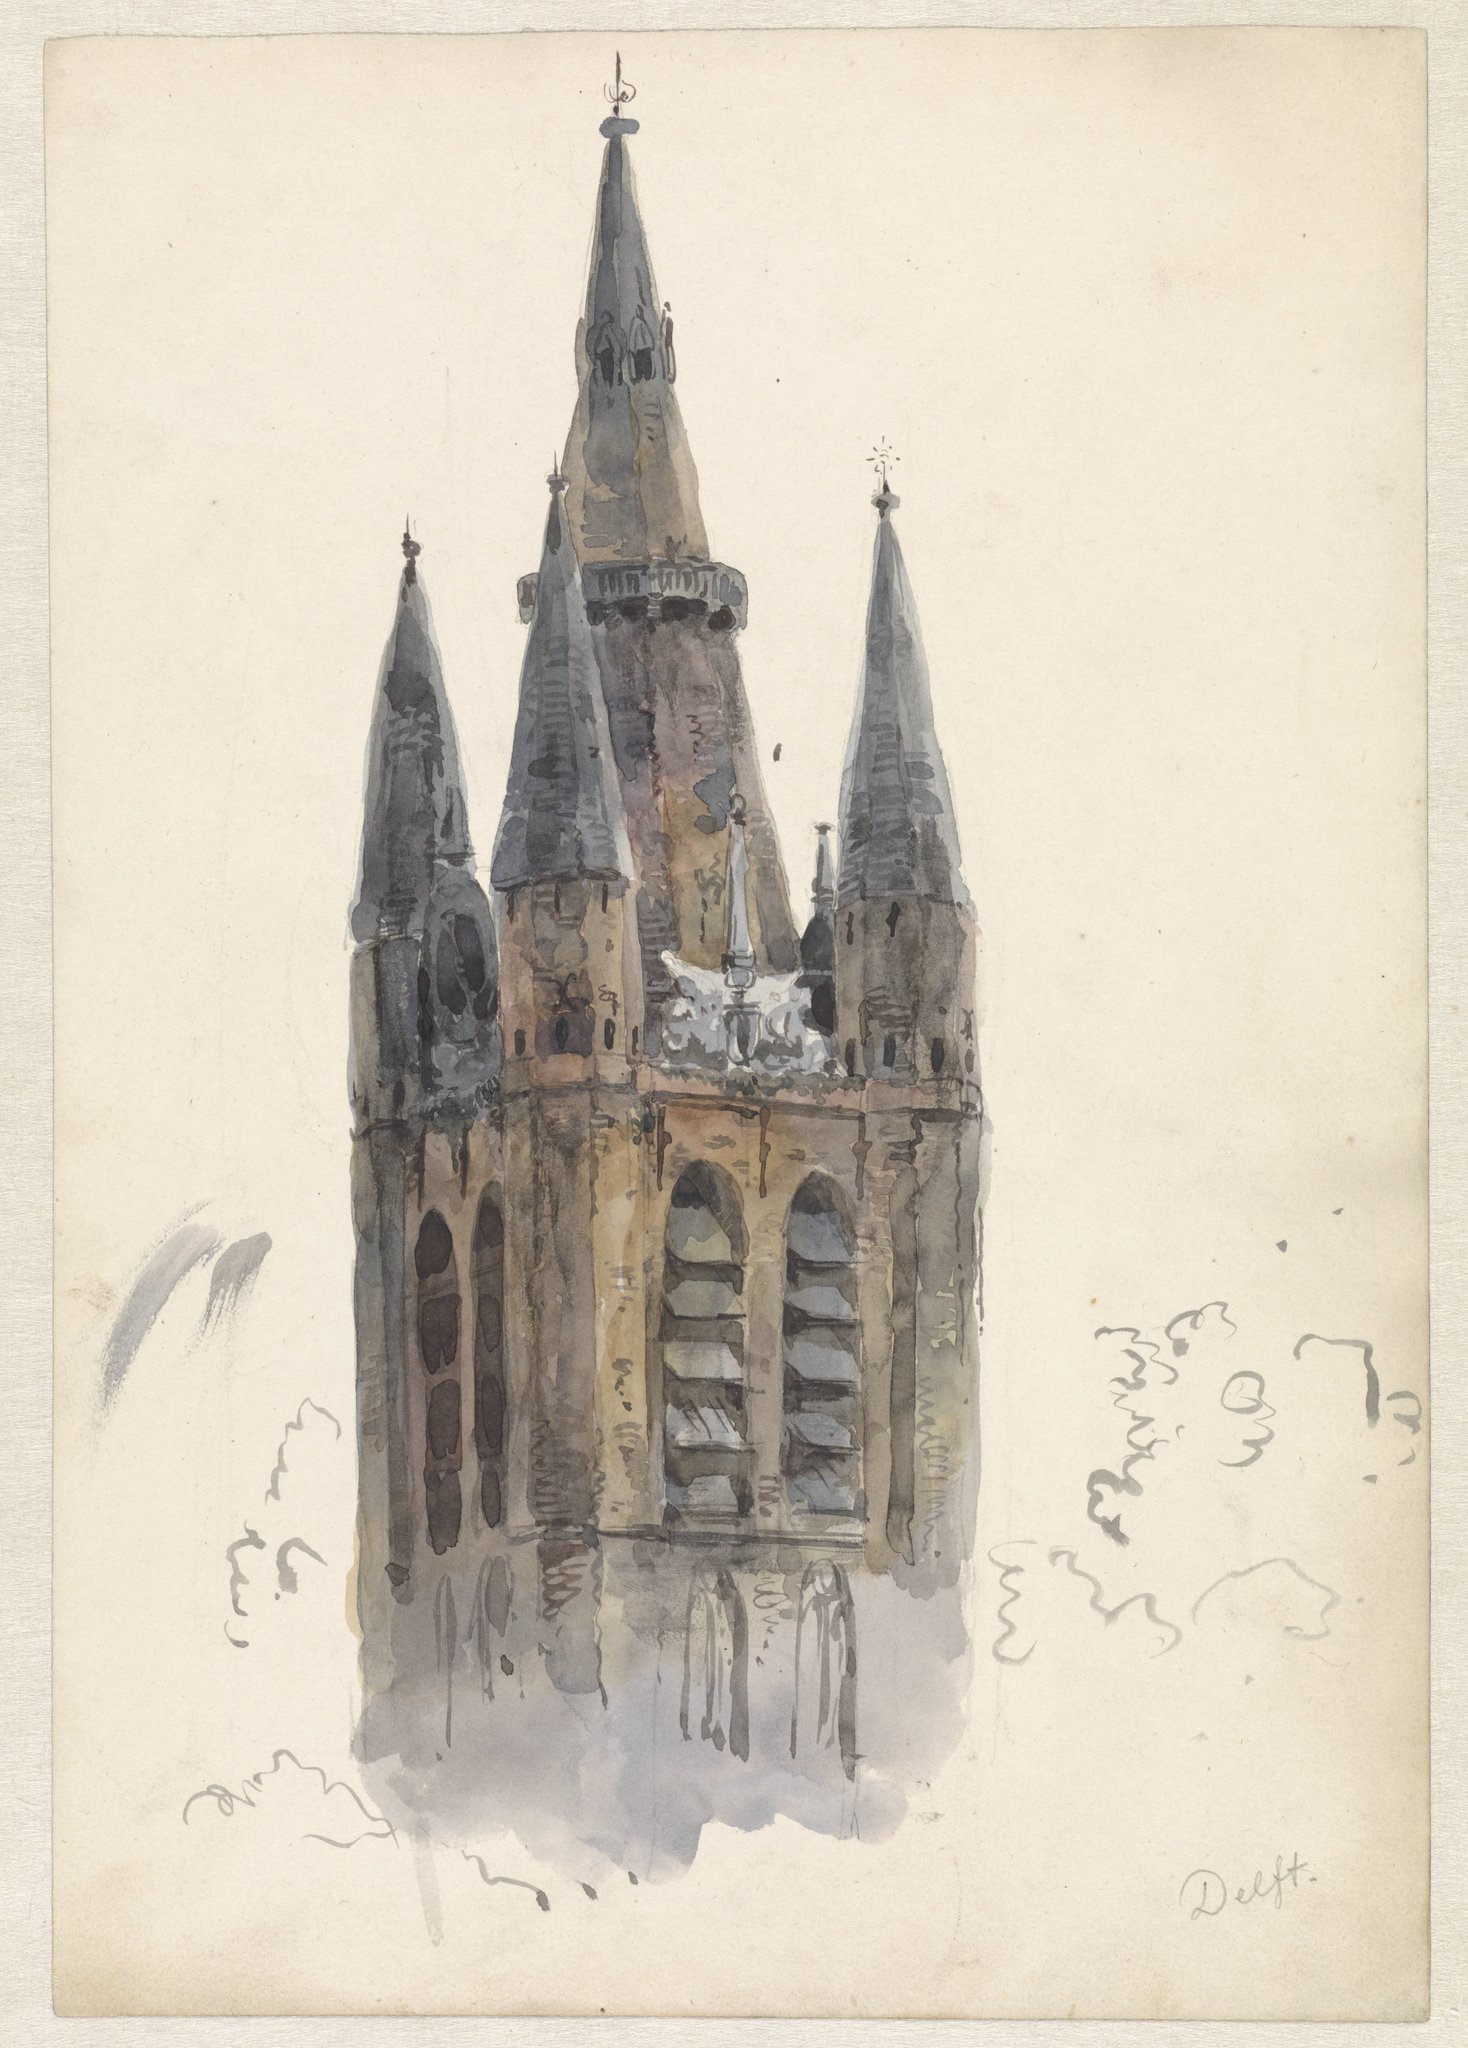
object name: drawing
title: Kerktoren te Delft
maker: willem anthonie van deventer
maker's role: draughtsman, painter, print maker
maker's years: 1824-1893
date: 1834-1893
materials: paper, pencil, watercolor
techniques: brush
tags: church (exterior), delft